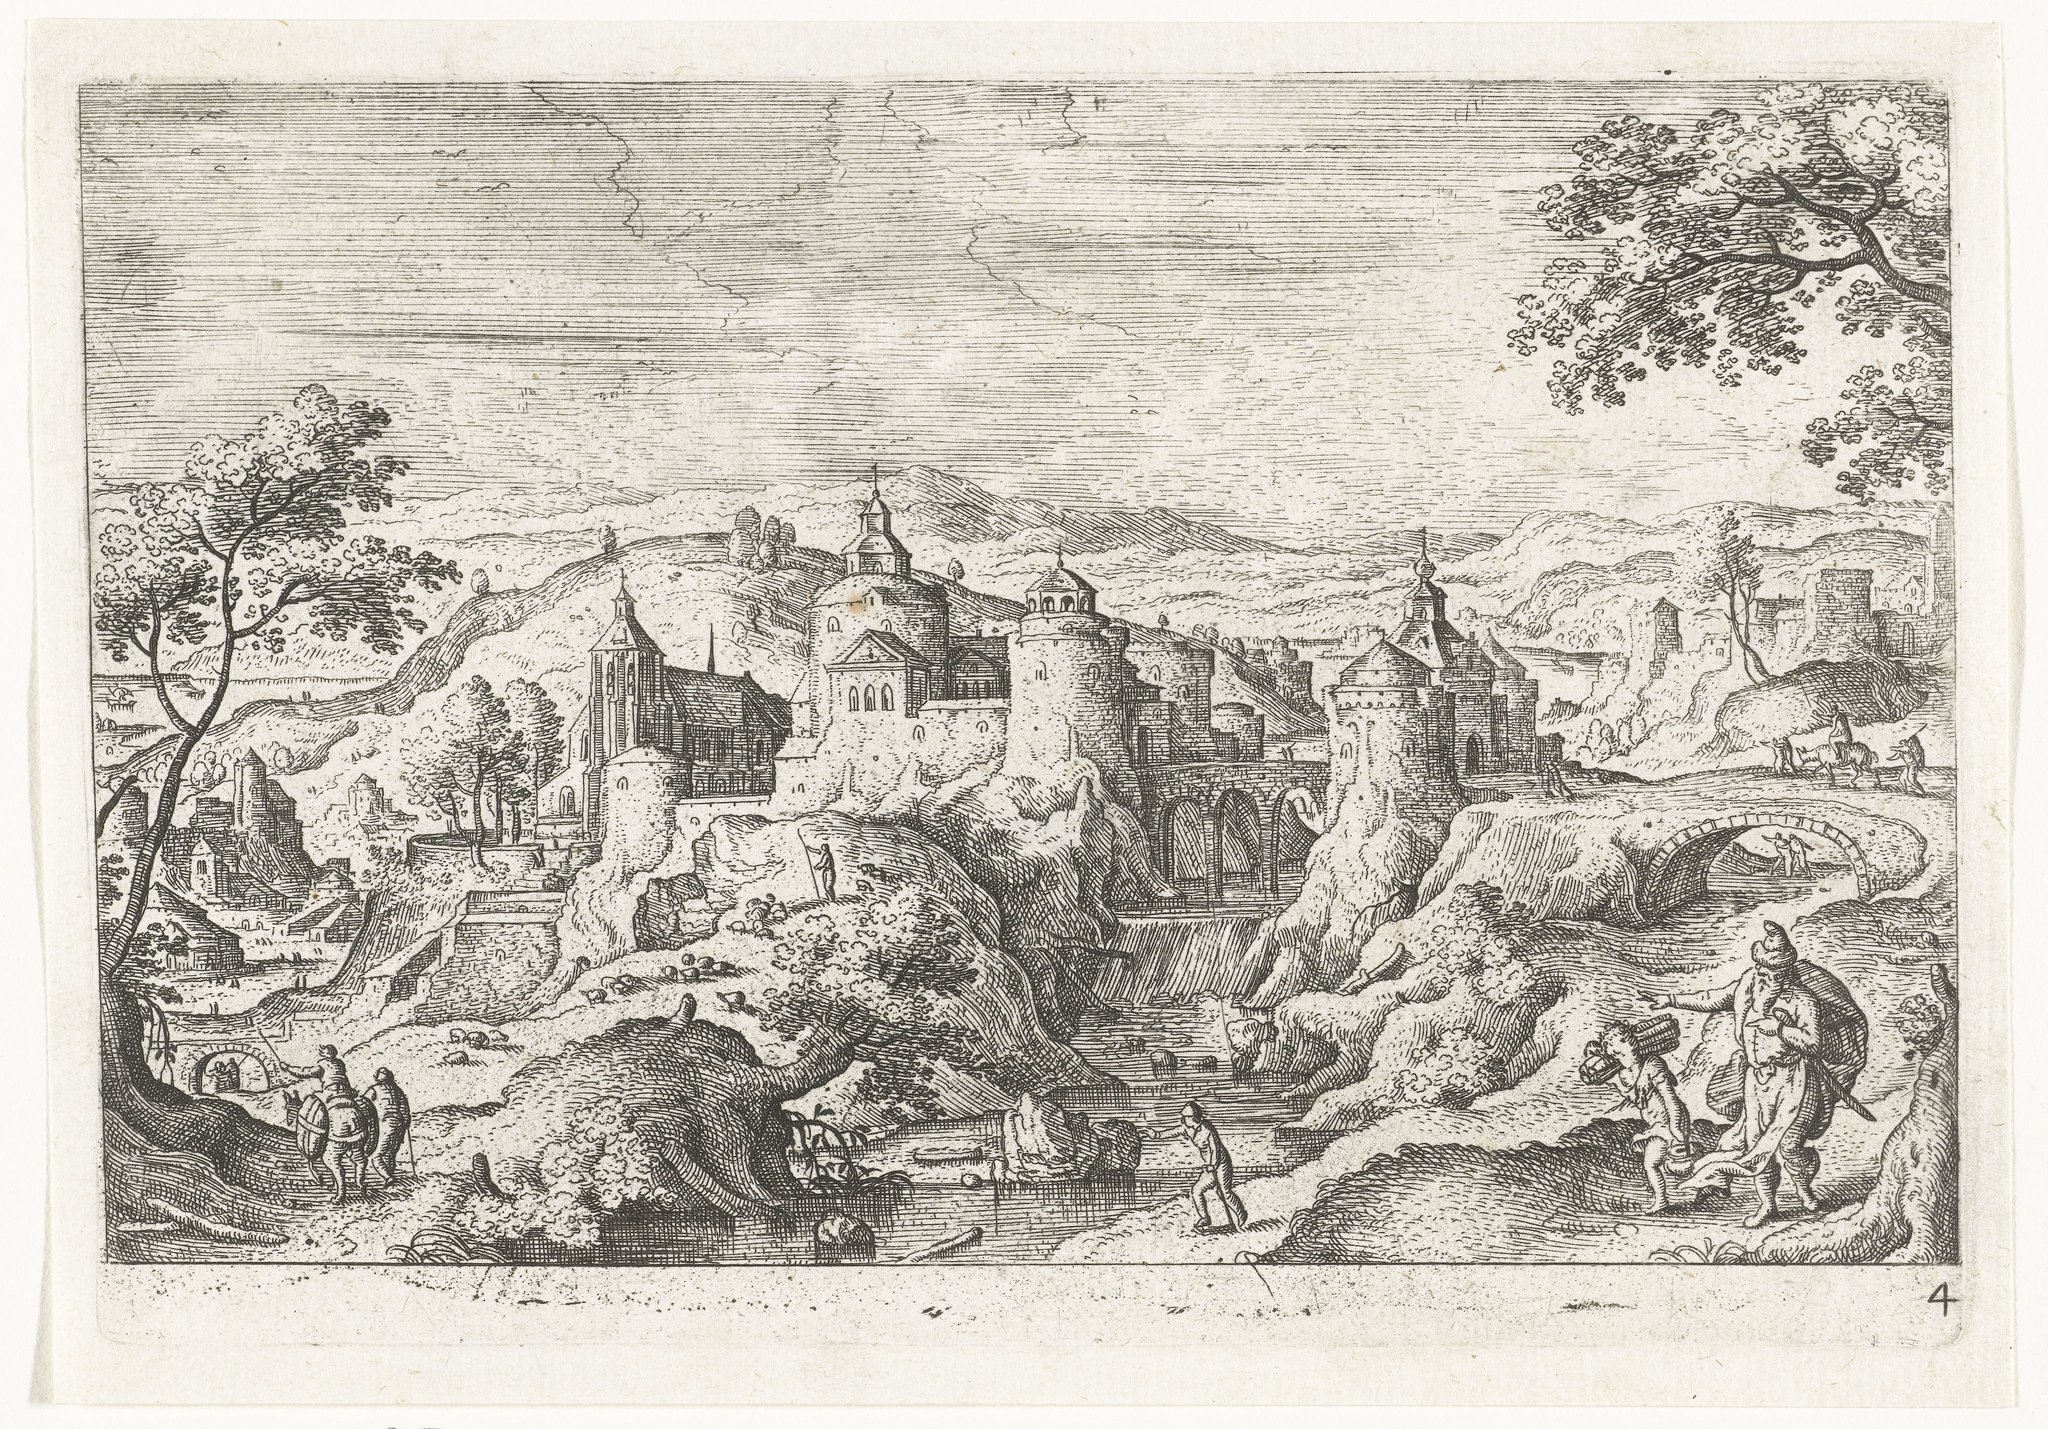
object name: print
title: Abraham en Isaak op weg naar de offerplaats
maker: Anonymous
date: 1550-1650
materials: paper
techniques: etching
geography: southern netherlands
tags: the servants are left behind while abraham and isaac (usually carrying wood) climb the mountain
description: Serie van 30 genummerde prenten. Volgorde blijft onduidelijk, omdat de nummering van verschillende staten (met of zonder onderschrift) afwijkt.